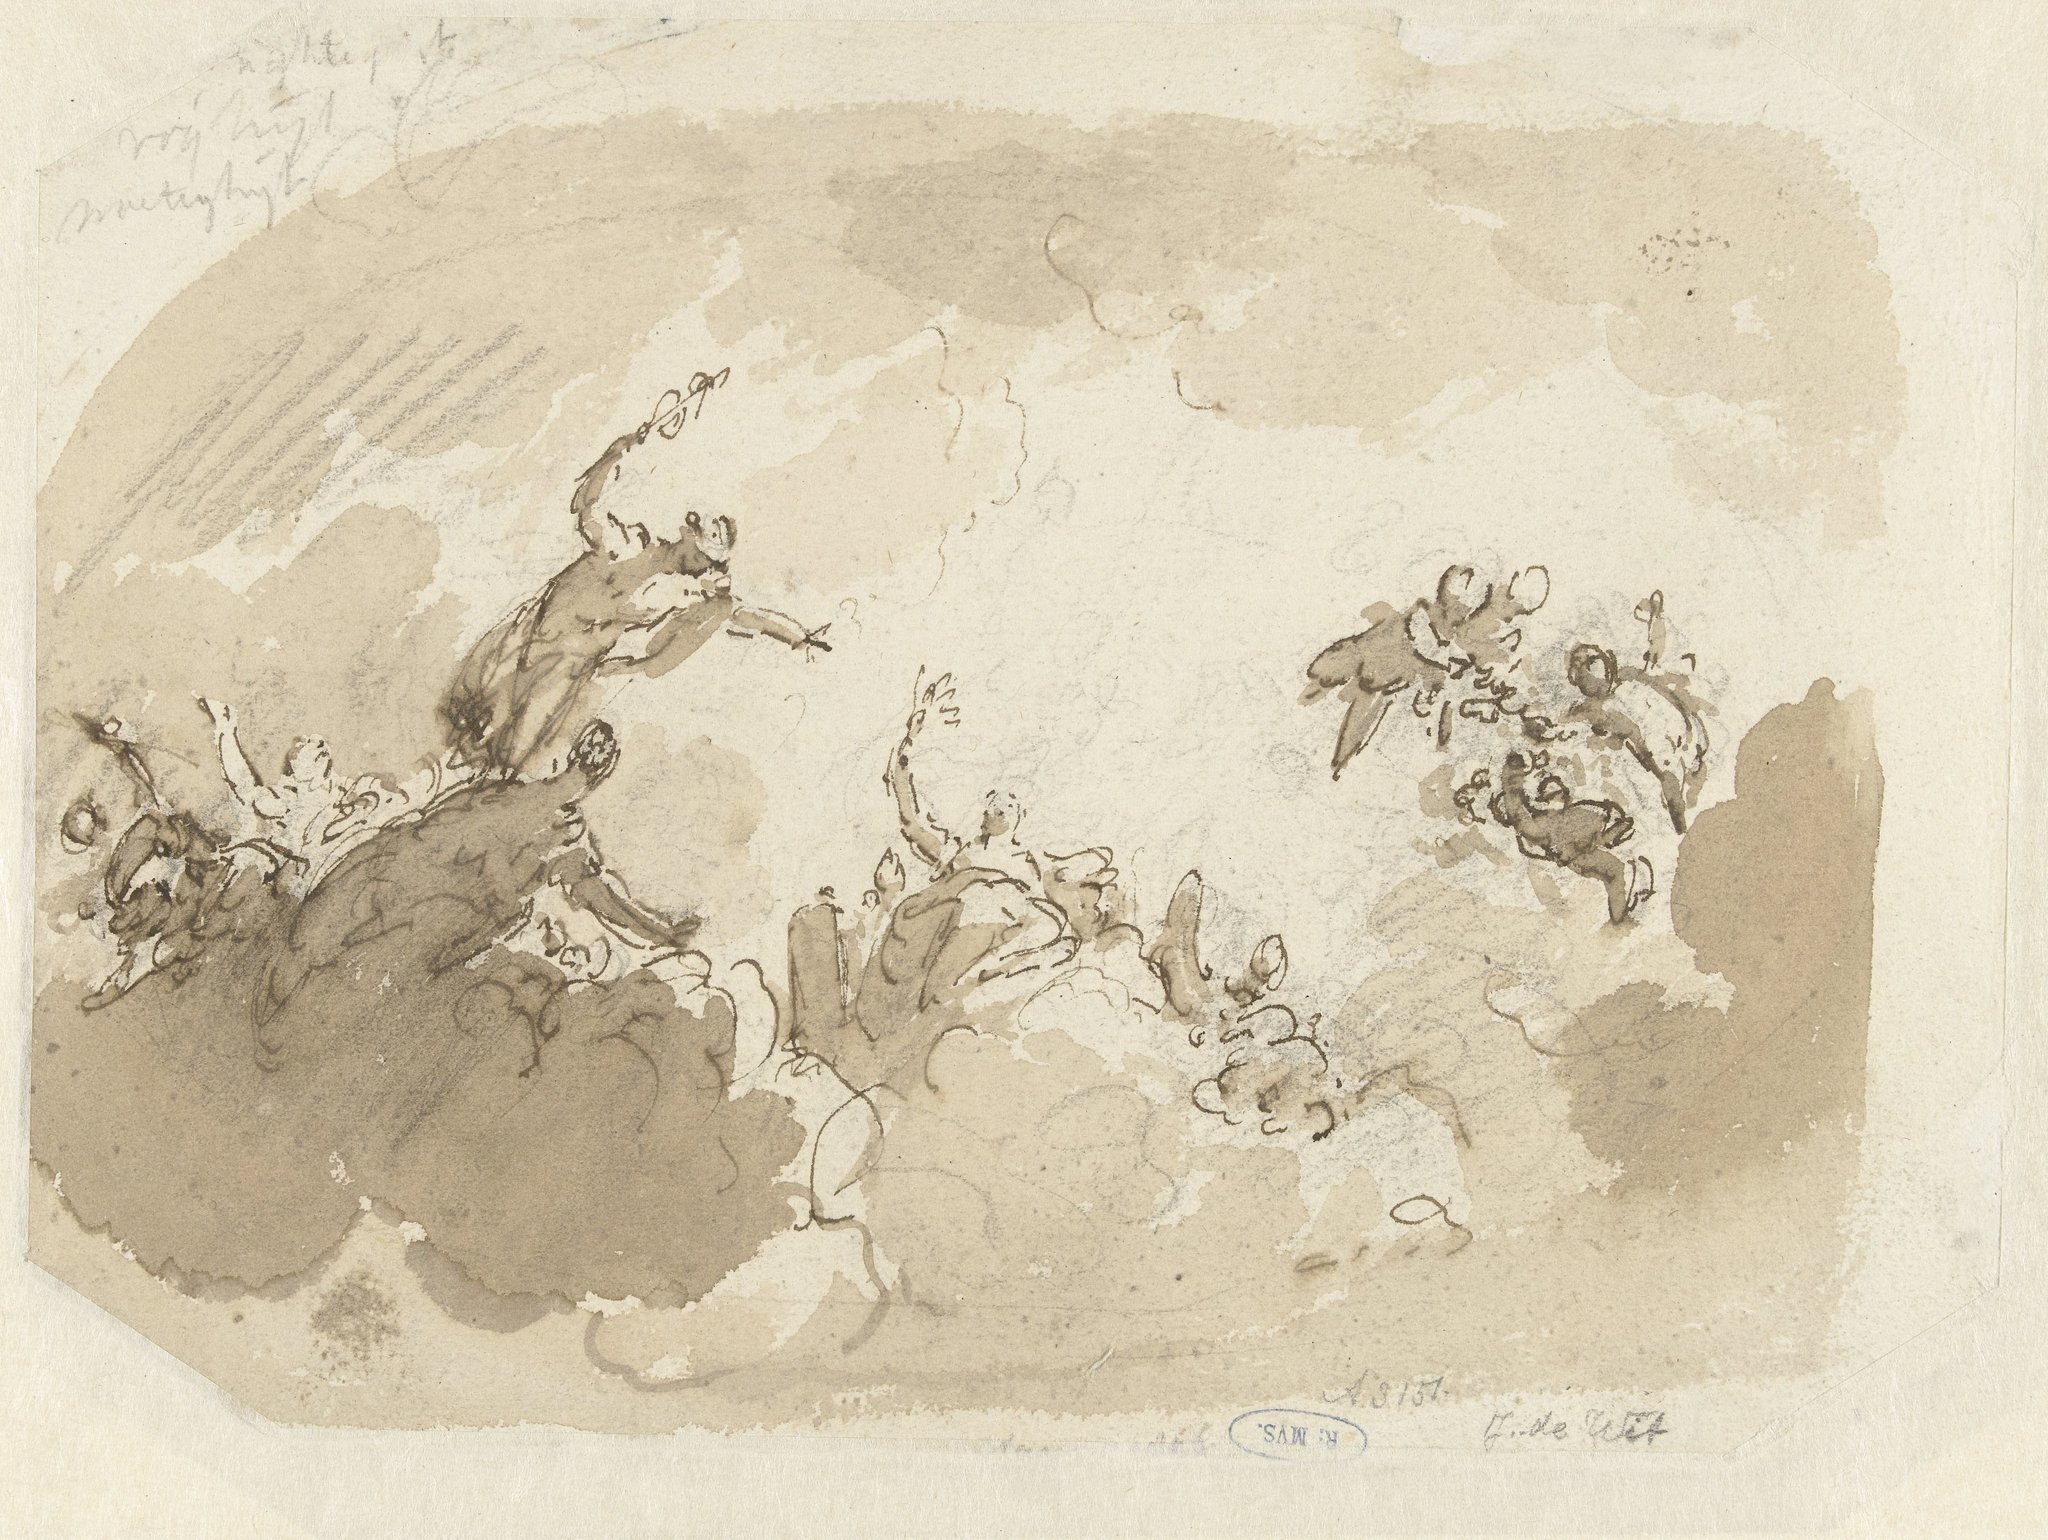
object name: drawing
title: Ontwerp voor plafondschildering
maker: jacob de wit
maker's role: draughtsman, painter, print maker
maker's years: 1695-1754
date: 1705-1754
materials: ink, paper, pencil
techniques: brush, pen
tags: flying, sitting or standing on clouds